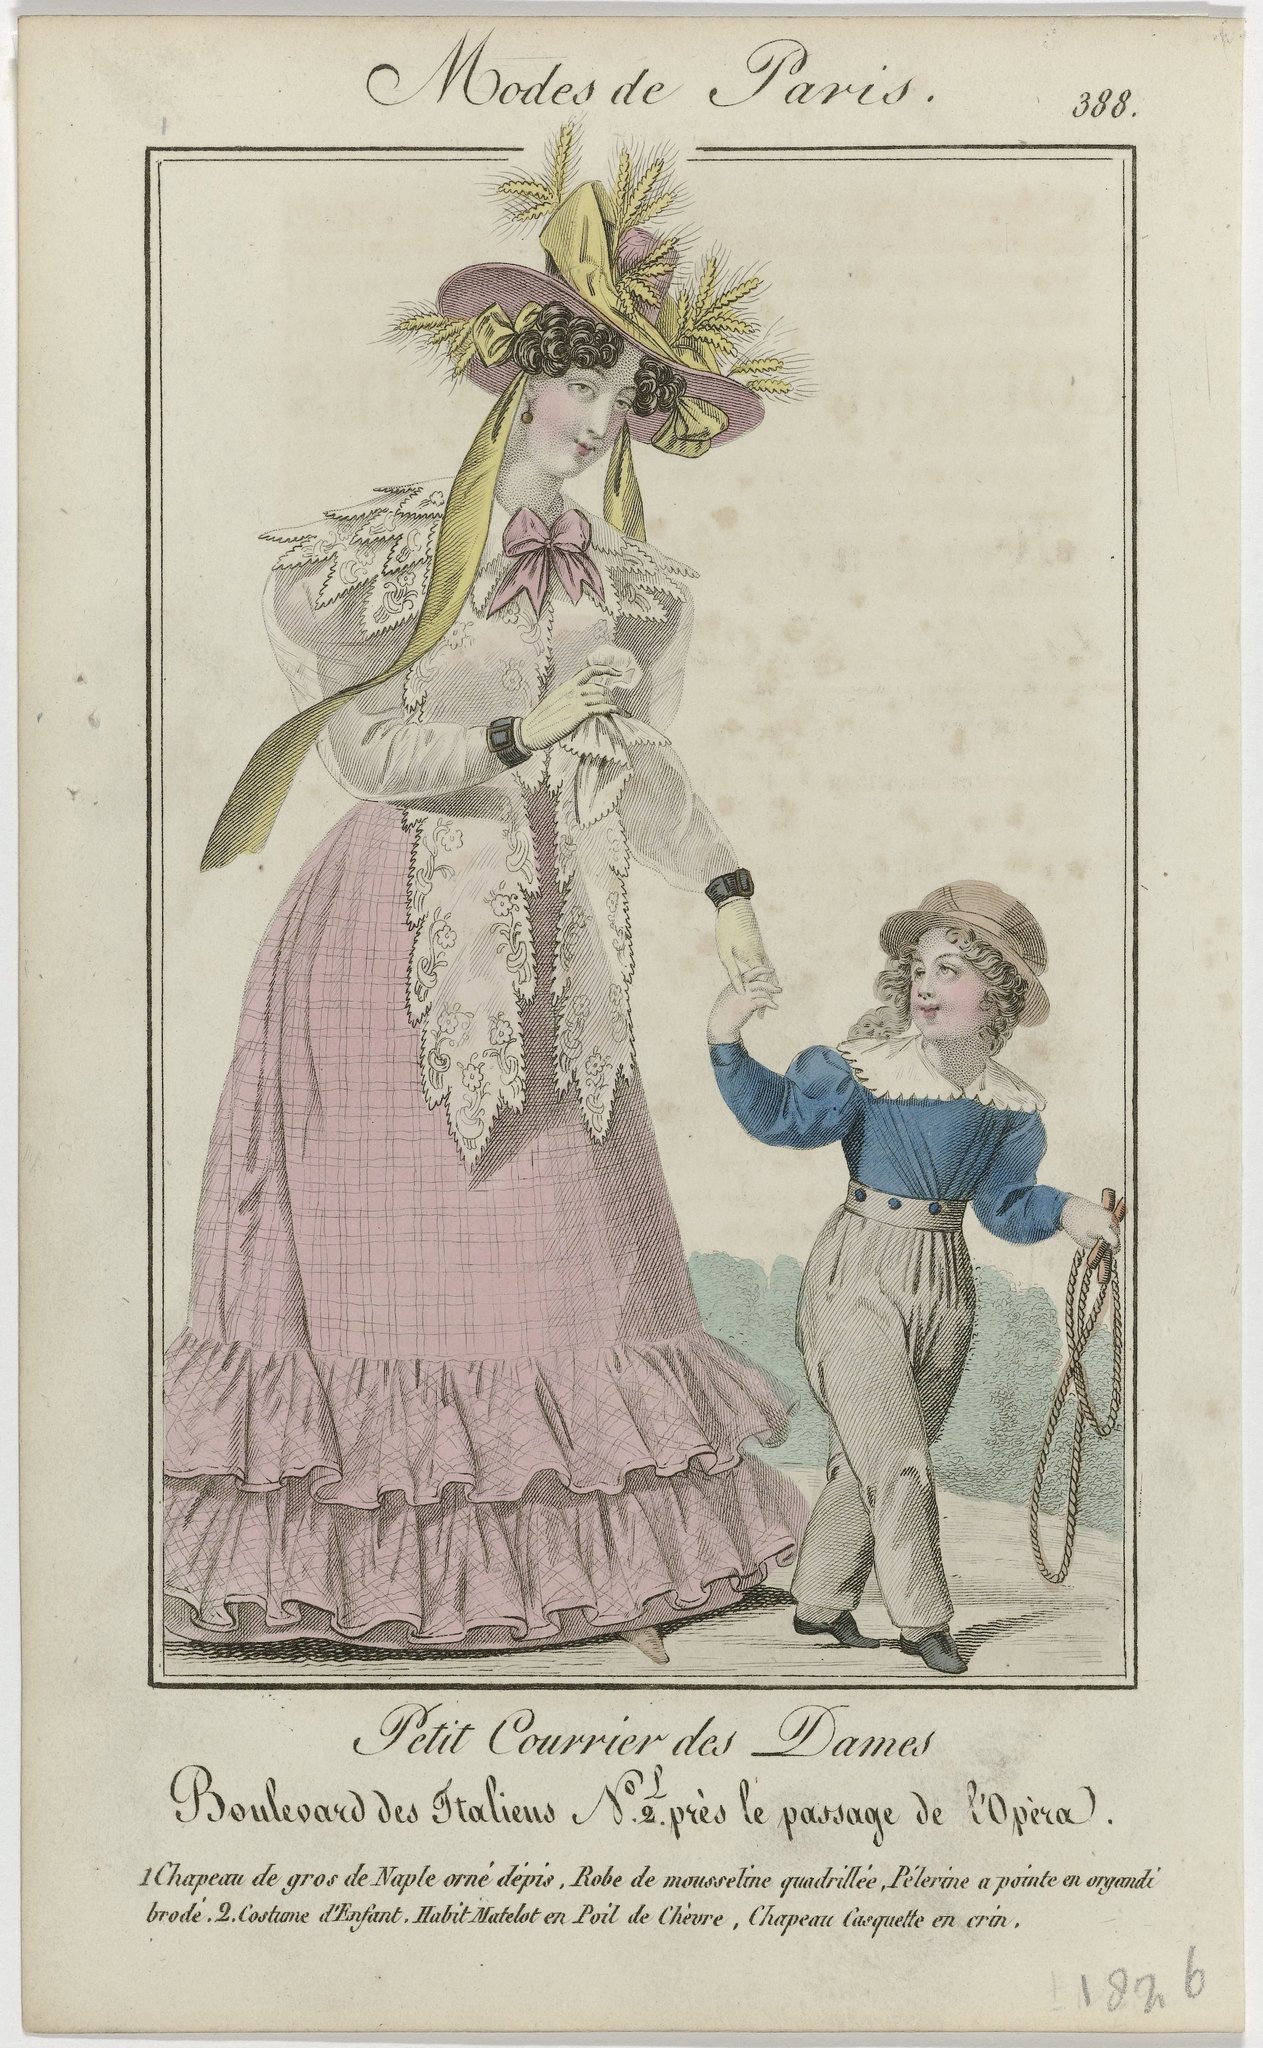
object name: fashion print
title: Petit Courrier des Dames, 1826, No. 388 : 1 Chapeau de gros de Napl (...)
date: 1826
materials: paper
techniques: engraving, hand coloring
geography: paris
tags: handkerchief (+ women's clothes), embroidery (ornamentation) (+ women's clothes), clothing for the upper part of the body (pelerine) (+ women's clothes), trousers, breeches (+ boys' clothes), head-gear: hat (+ boys' clothes), clothing for the upper part of the body (+ boys' clothes), fashion plates, head-gear: hat (+ women's clothes), dress, gown (+ women's clothes), muff (+ fur used for clothes), jumping-rope games, bracelet, wristlet (+ women's clothes)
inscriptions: address: ‘Boulevard des Italiens No.2 près le passage de l'Opera’, title: ‘Petit Courrier des Dames.’, caption: ‘1 Chapeau de gros de Naple orné dépis. Robe de mousseline quadrillée, Pélerine a pointe en organdi brodé. 2. Costume d'Enfant. Habit Matelot en Poil de Chèvre, Chapeau Casquette en crin.’, title: ‘Modes de Paris.’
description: Een vrouw met aan de hand een jongen met springtouw, genummerd één en twee. 1. Hoed van 'gros de Naples', versierd met aren. Japon van geruite mousseline. Doorzichtige schapenboutmouwen, waaronder lange mouwen. Pelerine met punten van geborduurde organdie. Verdere accessoires: oorbel in het rechteroor, handschoenen, armbanden om beide polsen, zakdoek. 2. Kinderkleding. Matrozenpak van geitenwol. Hoed of 'chapeau casquette' van 'crin'. Prent uit het modetijdschrift Petit Courrier des Dames (1821-1868).